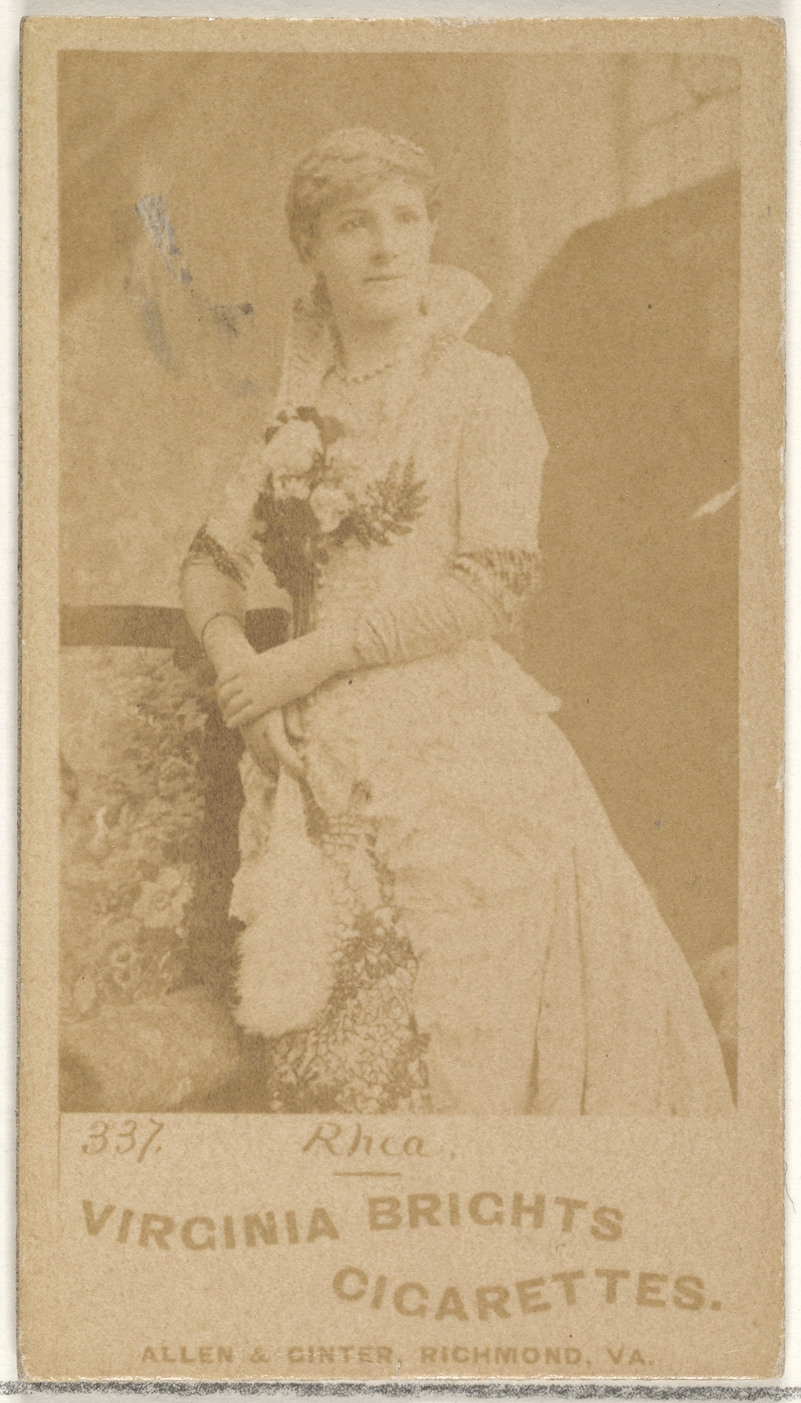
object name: photograph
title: Card 337, Rhea, from the Actors and Actresses series (N45, Type 1) for Virginia Brights Cigarettes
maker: allen & ginter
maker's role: publisher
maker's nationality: american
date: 1888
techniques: albumen silver print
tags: portraits,women,actresses